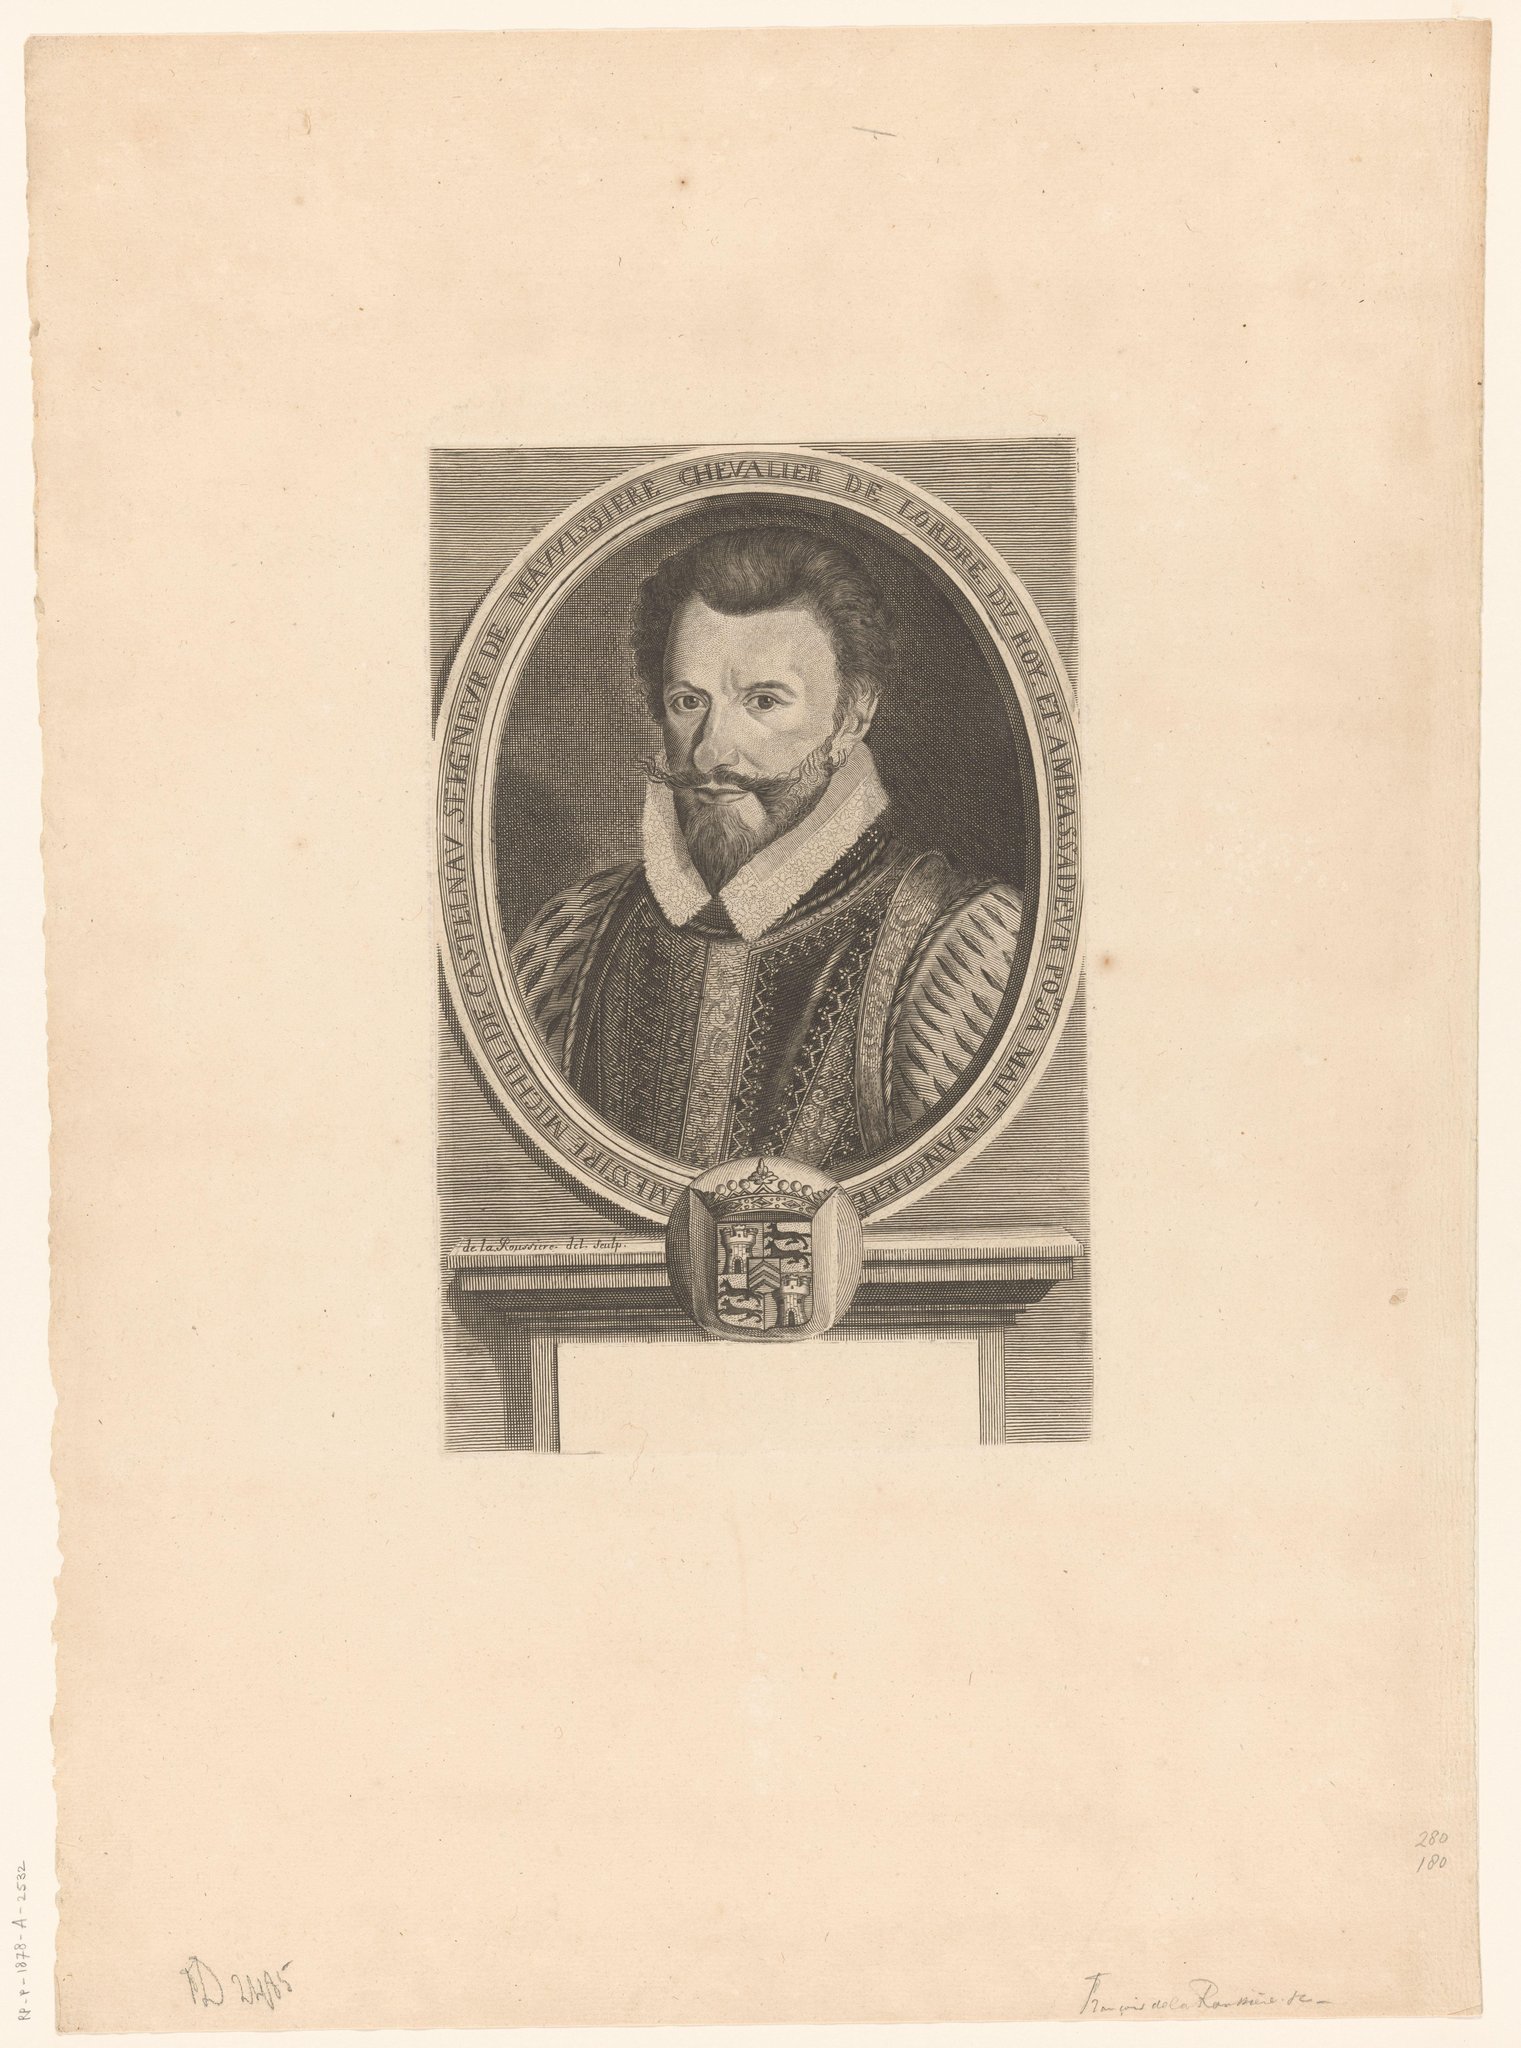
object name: print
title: Portret van Michel de Castelnau, Sieur de la Mauvissière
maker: françois de la roussière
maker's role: print maker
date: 1655-1665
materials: paper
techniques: engraving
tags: historical persons, armorial bearing, heraldry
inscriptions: collector's mark: Lugt 684, collector's mark: Lugt 2228, collector's mark: Lugt 253